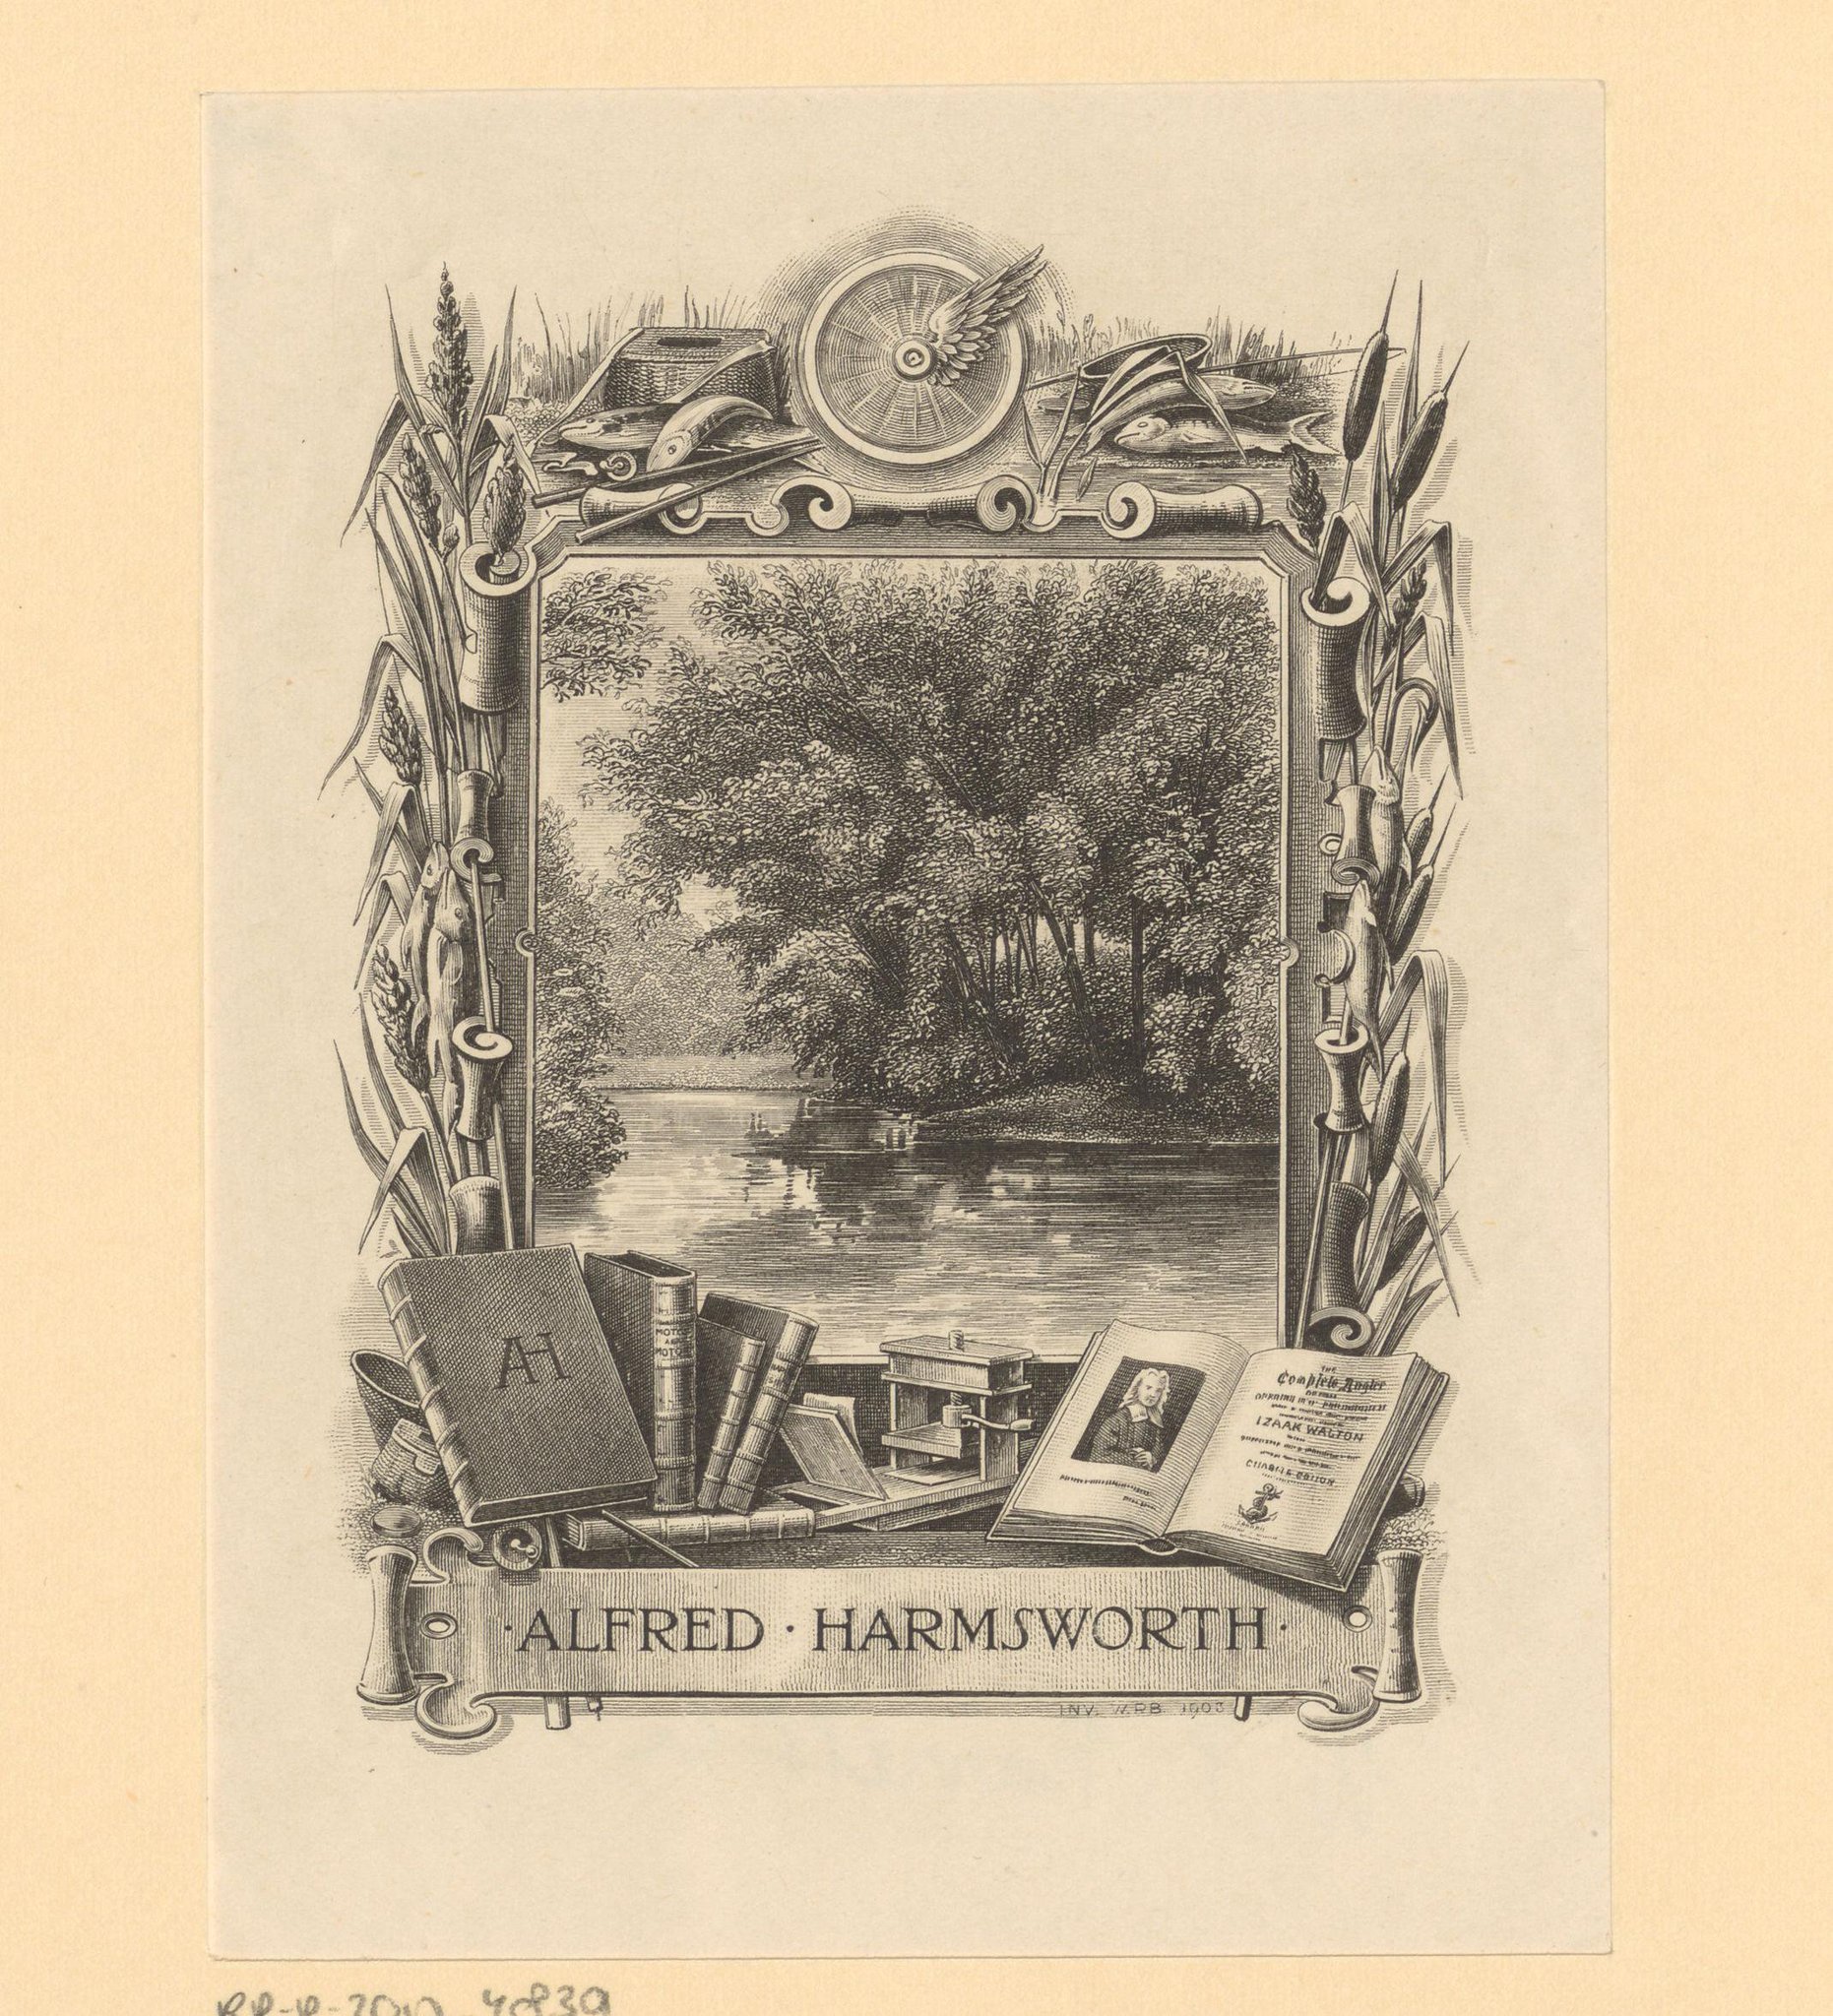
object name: bookplate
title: Ex libris van Alfred Harmsworth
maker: william phillips barrett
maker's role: print maker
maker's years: 1861-1938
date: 1903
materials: paper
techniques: etching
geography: england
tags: publisher, landscapes, printing press, fishes, book, plants and herbs: reed, pond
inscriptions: inscription: ‘W.P. Barrett sc.’